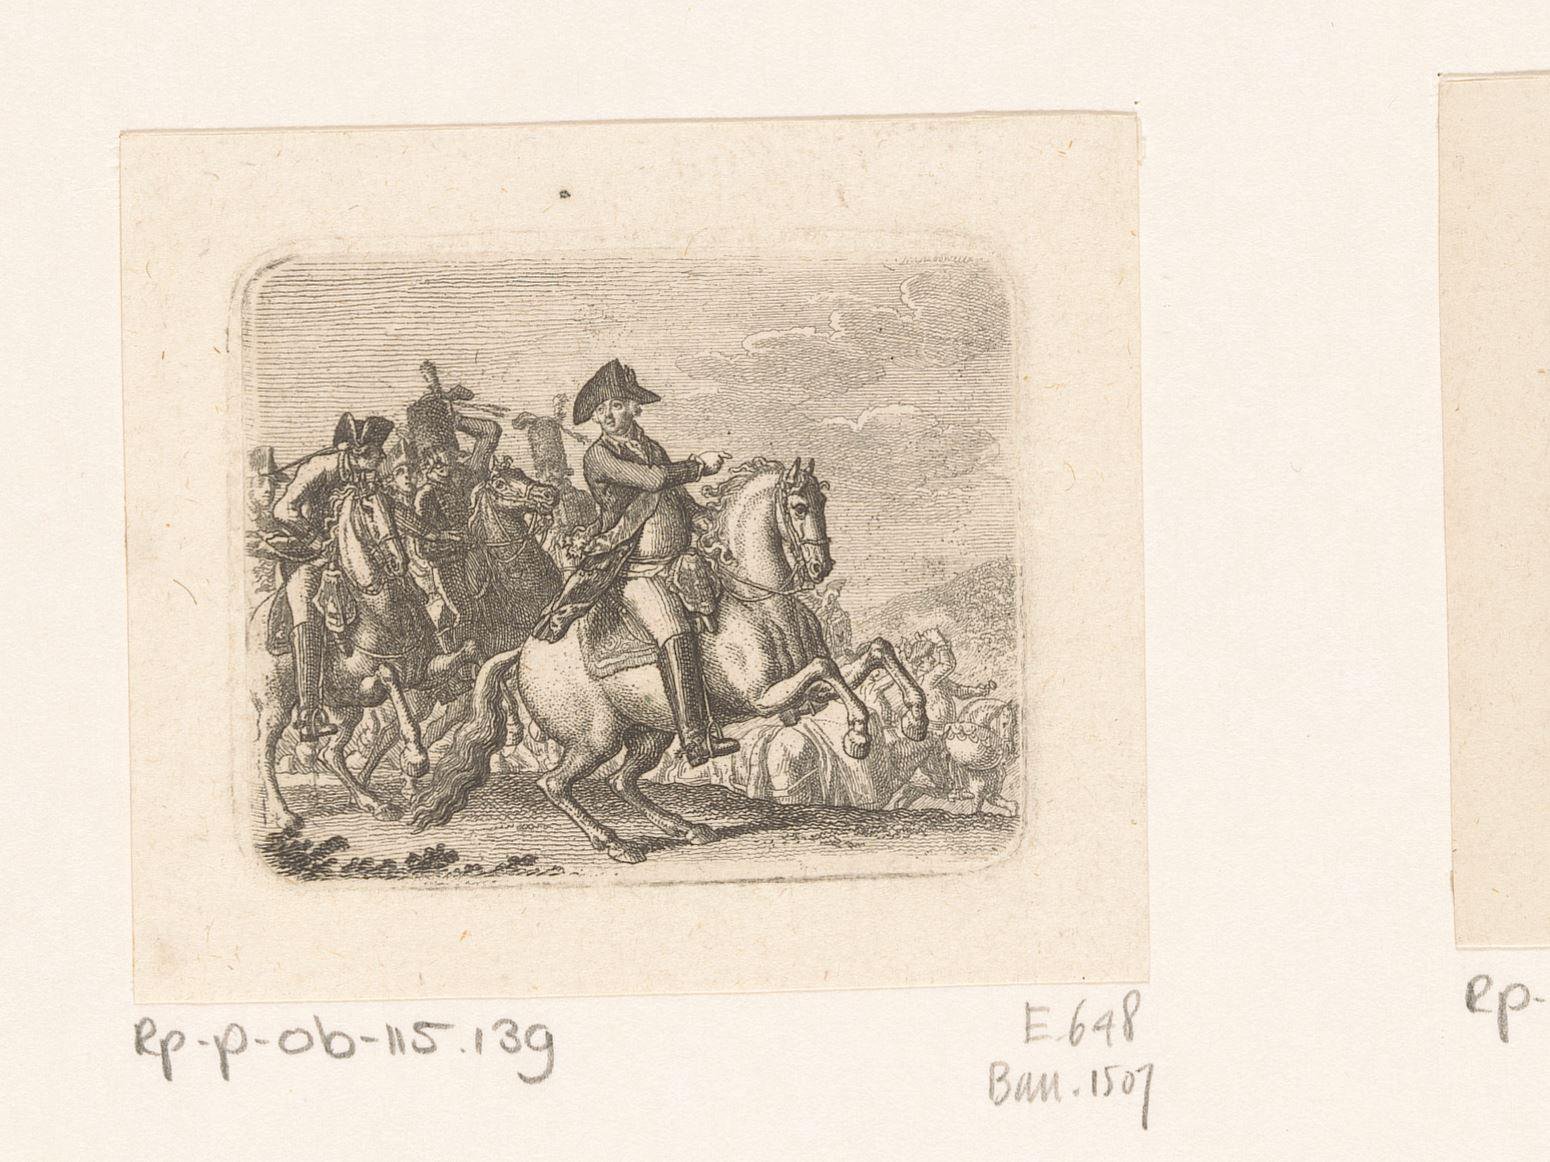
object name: print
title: Uittocht van het Pruisische leger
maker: daniel nikolaus chodowiecki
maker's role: draughtsman, print maker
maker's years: 1726-1801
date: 1790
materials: paper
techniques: etching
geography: berlin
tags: frederik willem ii (koning van pruisen), riding a horse, ass, or mule; rider, horseman, warfare; military affairs, ruler, sovereign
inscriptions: collector's mark: Lugt 2228